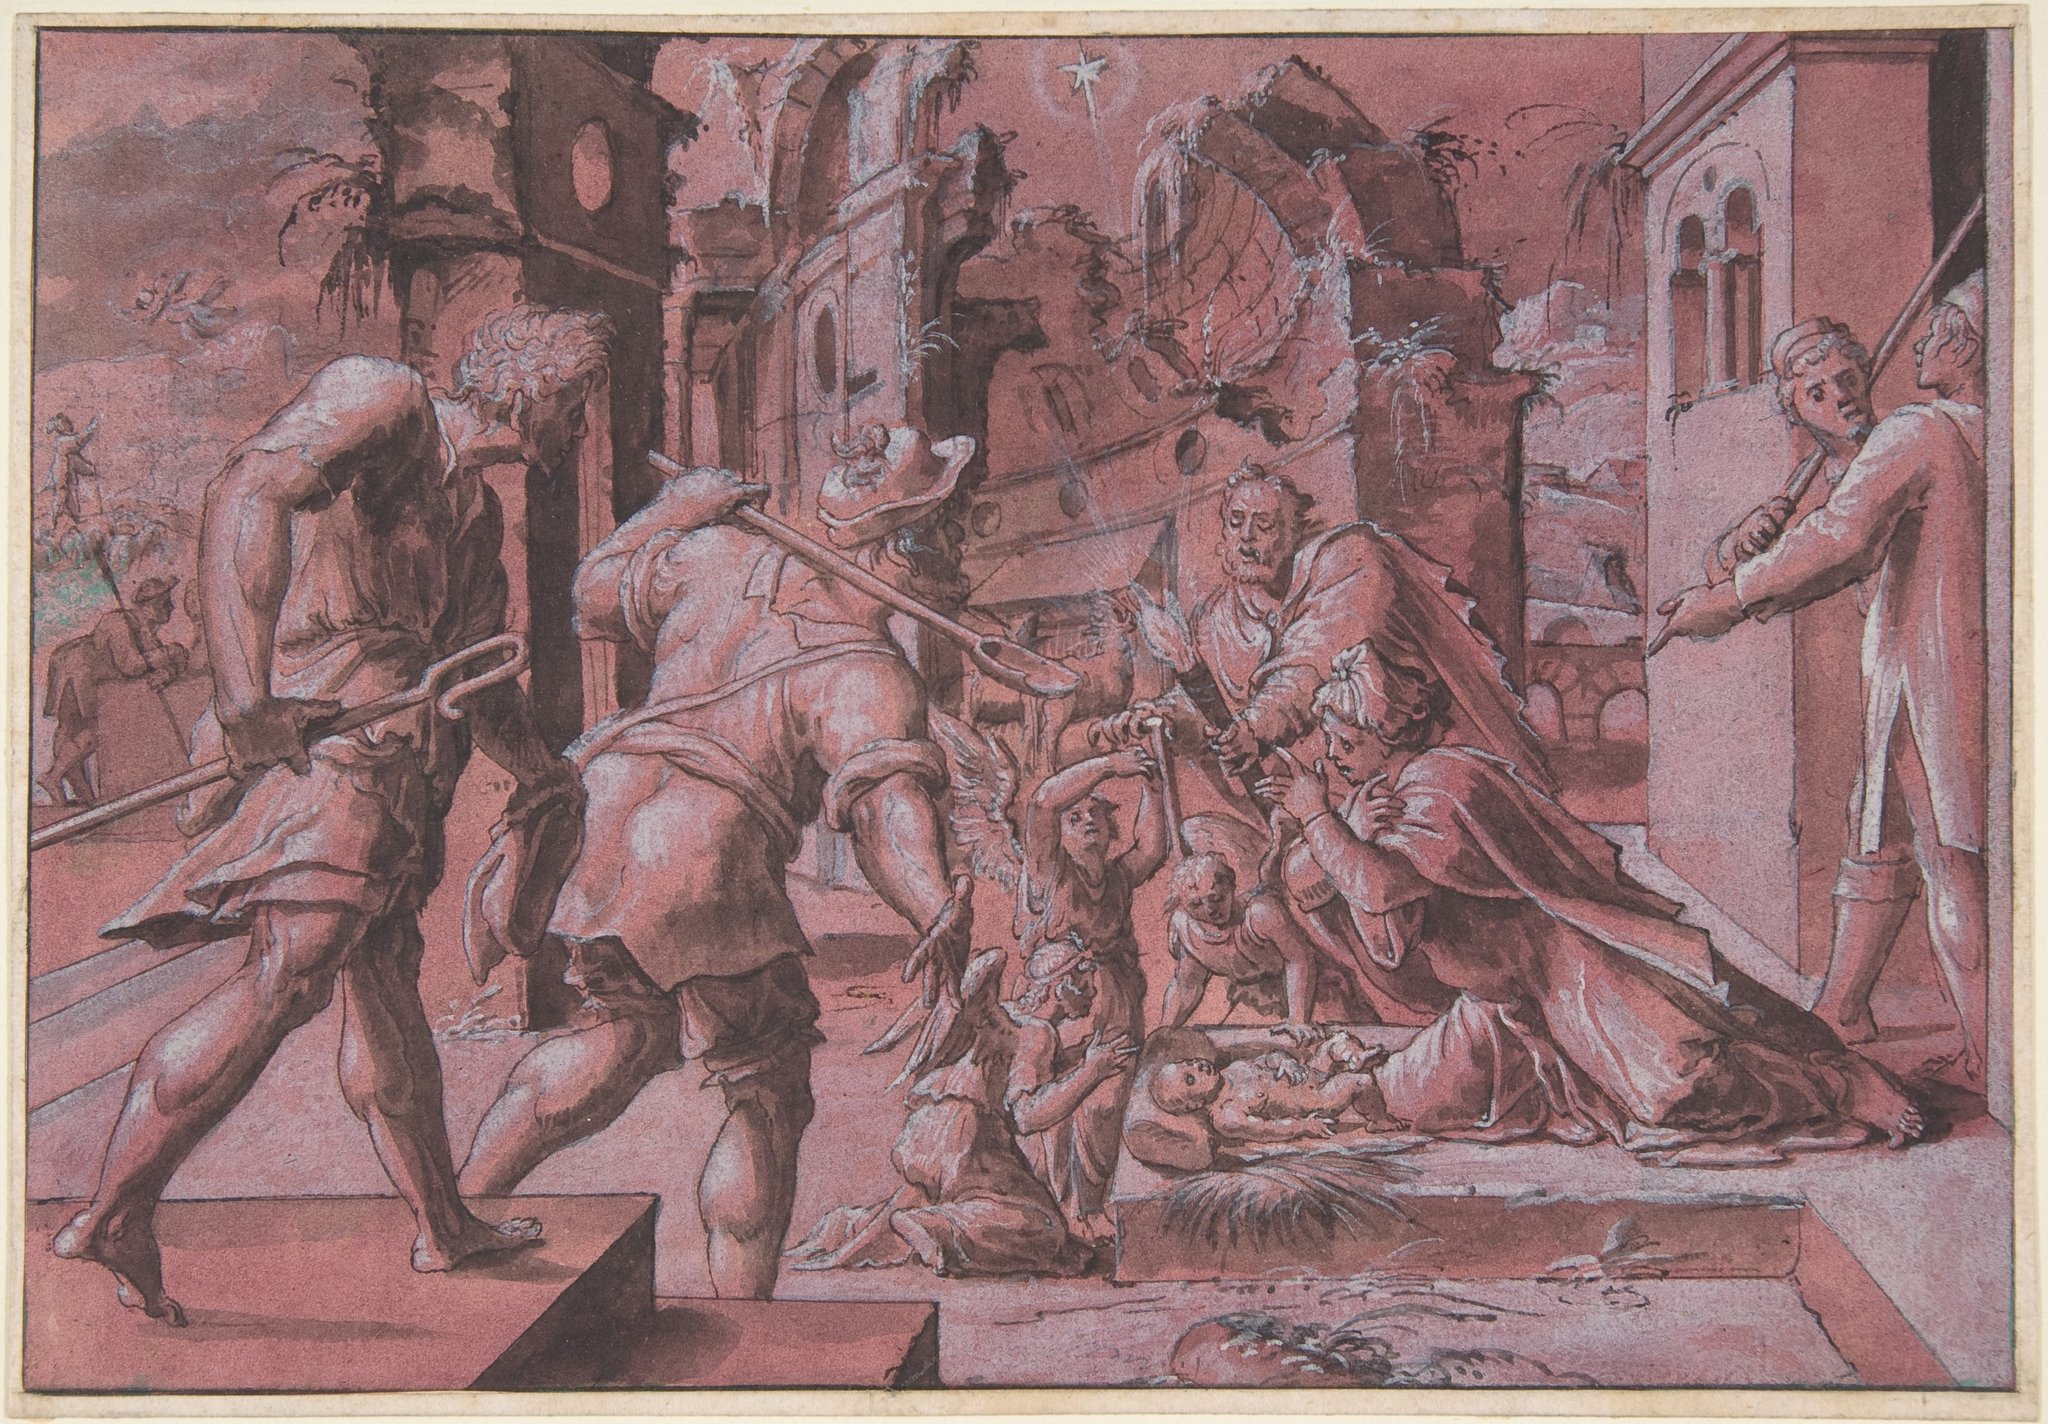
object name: drawing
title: Adoration of the Shepherds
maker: master of liechtenstein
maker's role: artist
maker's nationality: netherlandish (?)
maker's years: 1549-1550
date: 1540-1560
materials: gouache, ink, paper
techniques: heightening, pen, wash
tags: men,women,angels,adoration of the shepherds